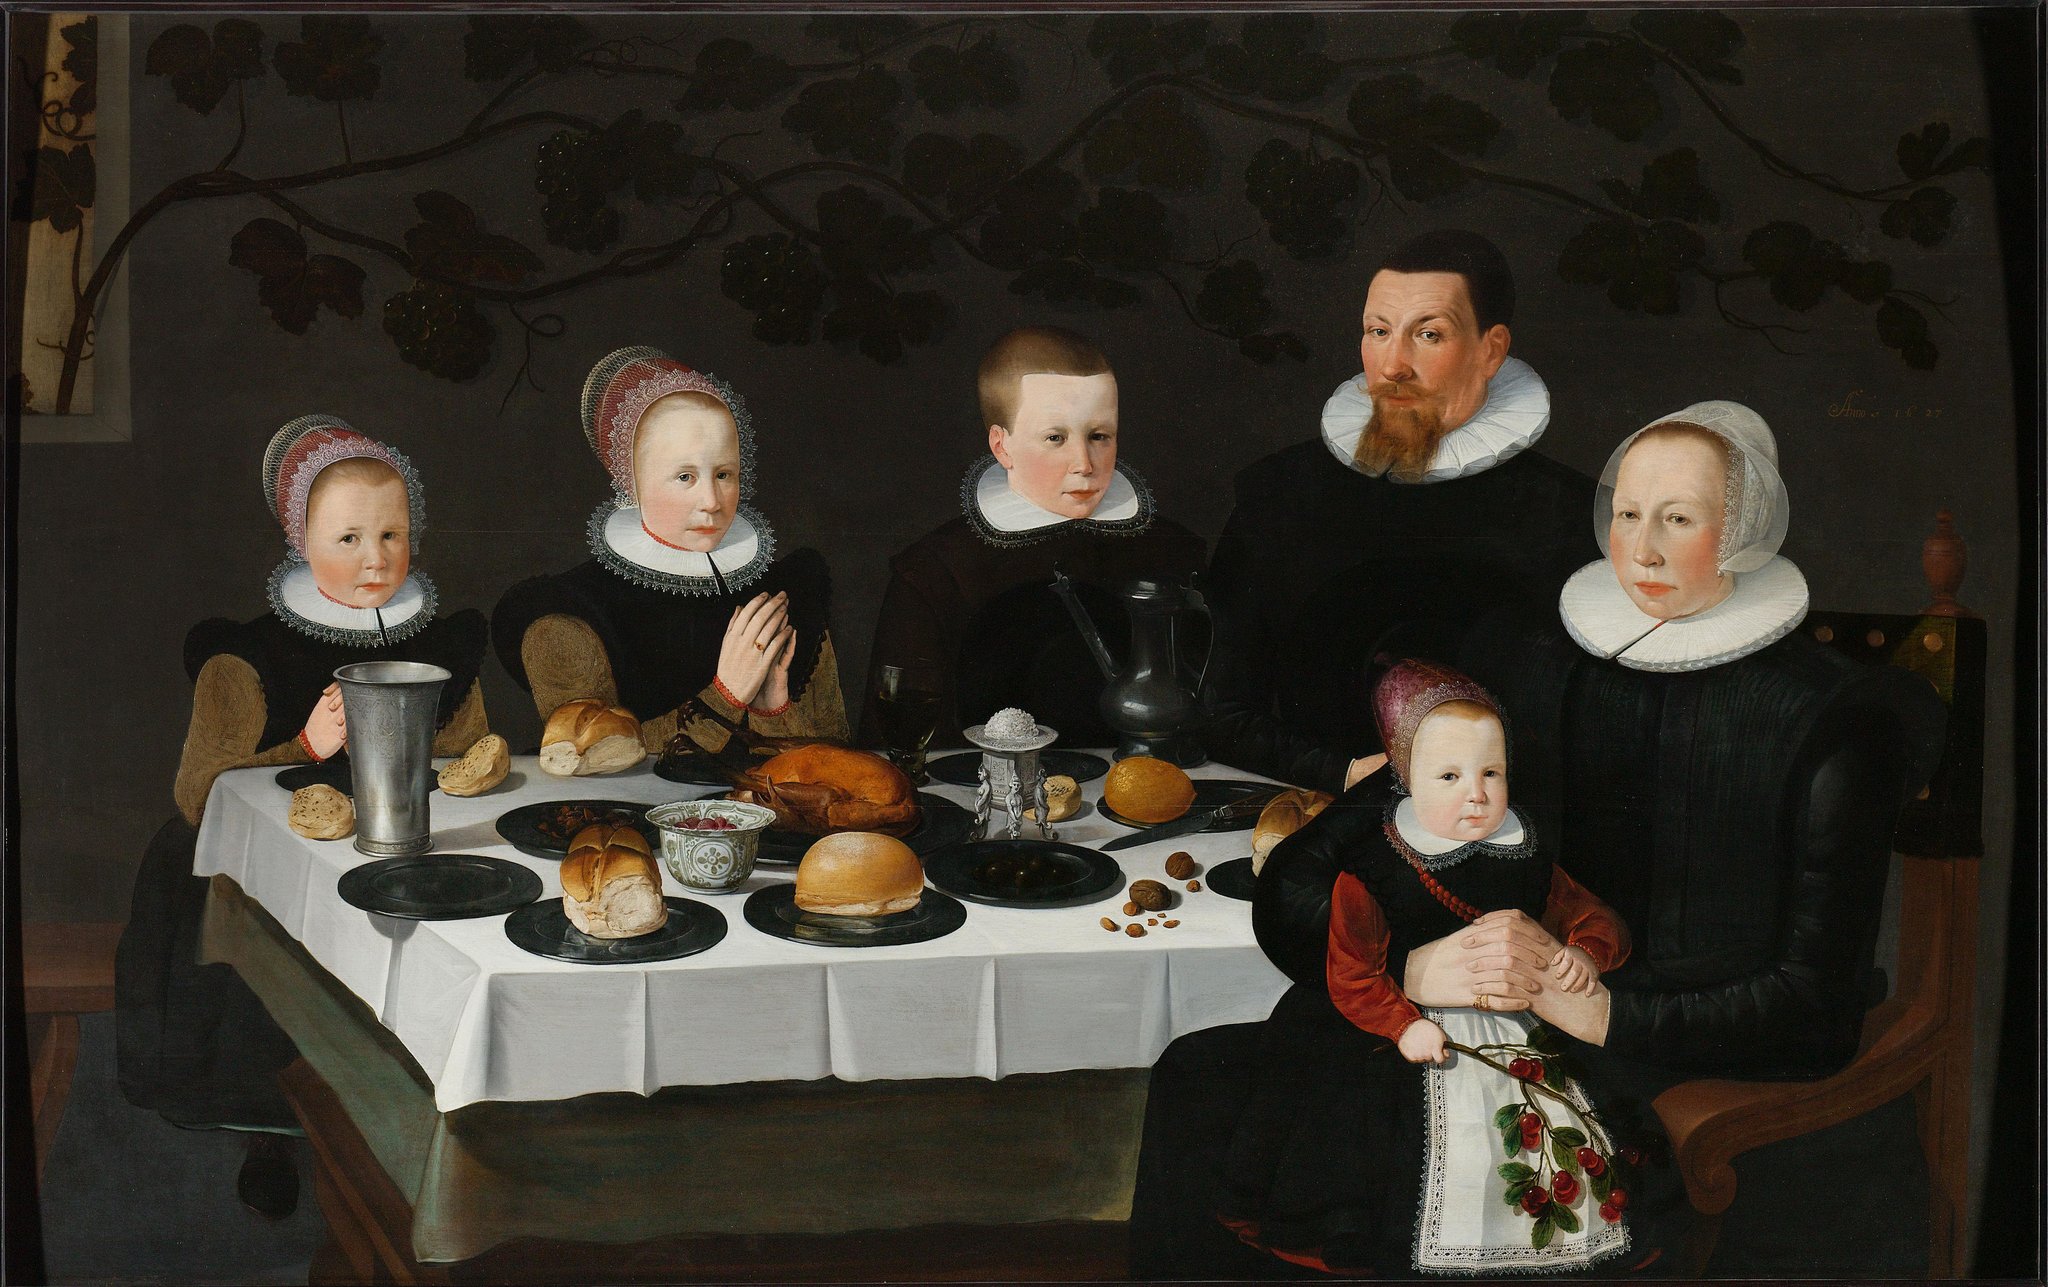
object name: painting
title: Prosperous Calvinist Family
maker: Anonymous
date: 1627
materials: oil, panel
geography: northern netherlands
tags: prayer at table, saying grace, (family) meal, historical persons not known by name, anonymous historical persons portrayed in a group, in a group-portrait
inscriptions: date: ‘Anno 1627’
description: Praying together and thanking God for our daily bread: just as it should be. This family’s faith is as resolute as the immaculately starched folds in the tablecloth. And it is prosperous, as indicated by the little Chinese dish with strawberries and the full saltcellar on the table (salt was expensive). The Word of God is paramount, as for all Protestants. The vine along the wall refers to Psalm 128: ‘Blessed are all who walk in obedience to the Lord; you will eat the fruit of your labour; blessings and prosperity will be yours.’